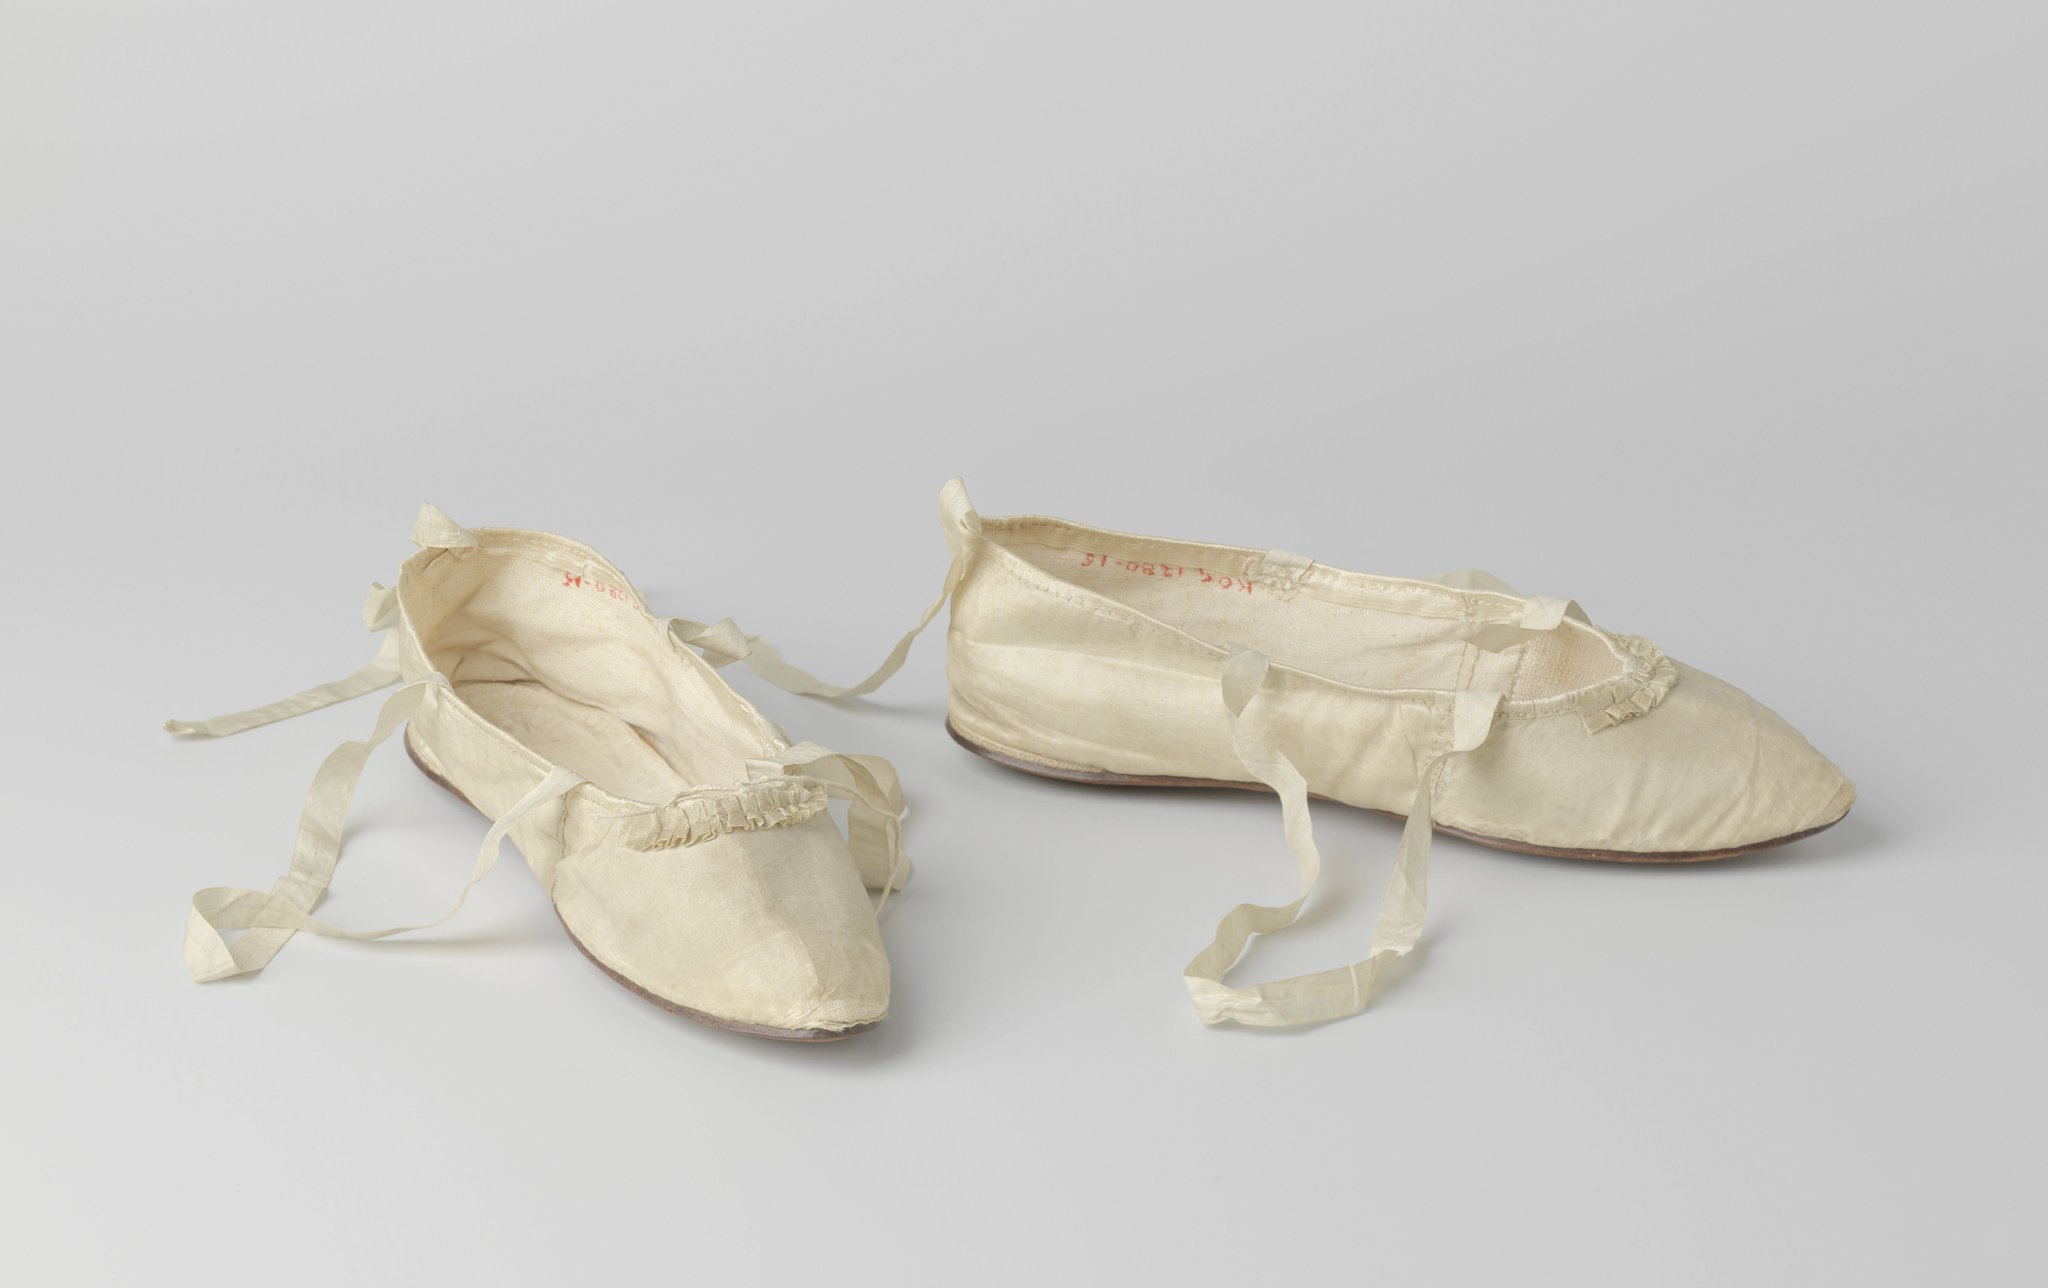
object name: shoe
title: Schoen van witte tafzijde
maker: Anonymous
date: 1800-1810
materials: silk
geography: northern netherlands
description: Schoen van witte tafzijde. Geen links/rechts verschil. Doorlopende puntige zool, geen hak, smalle ruche langs het uitgesneden voorblad. Kruisbandjes van lint. Zool van leer